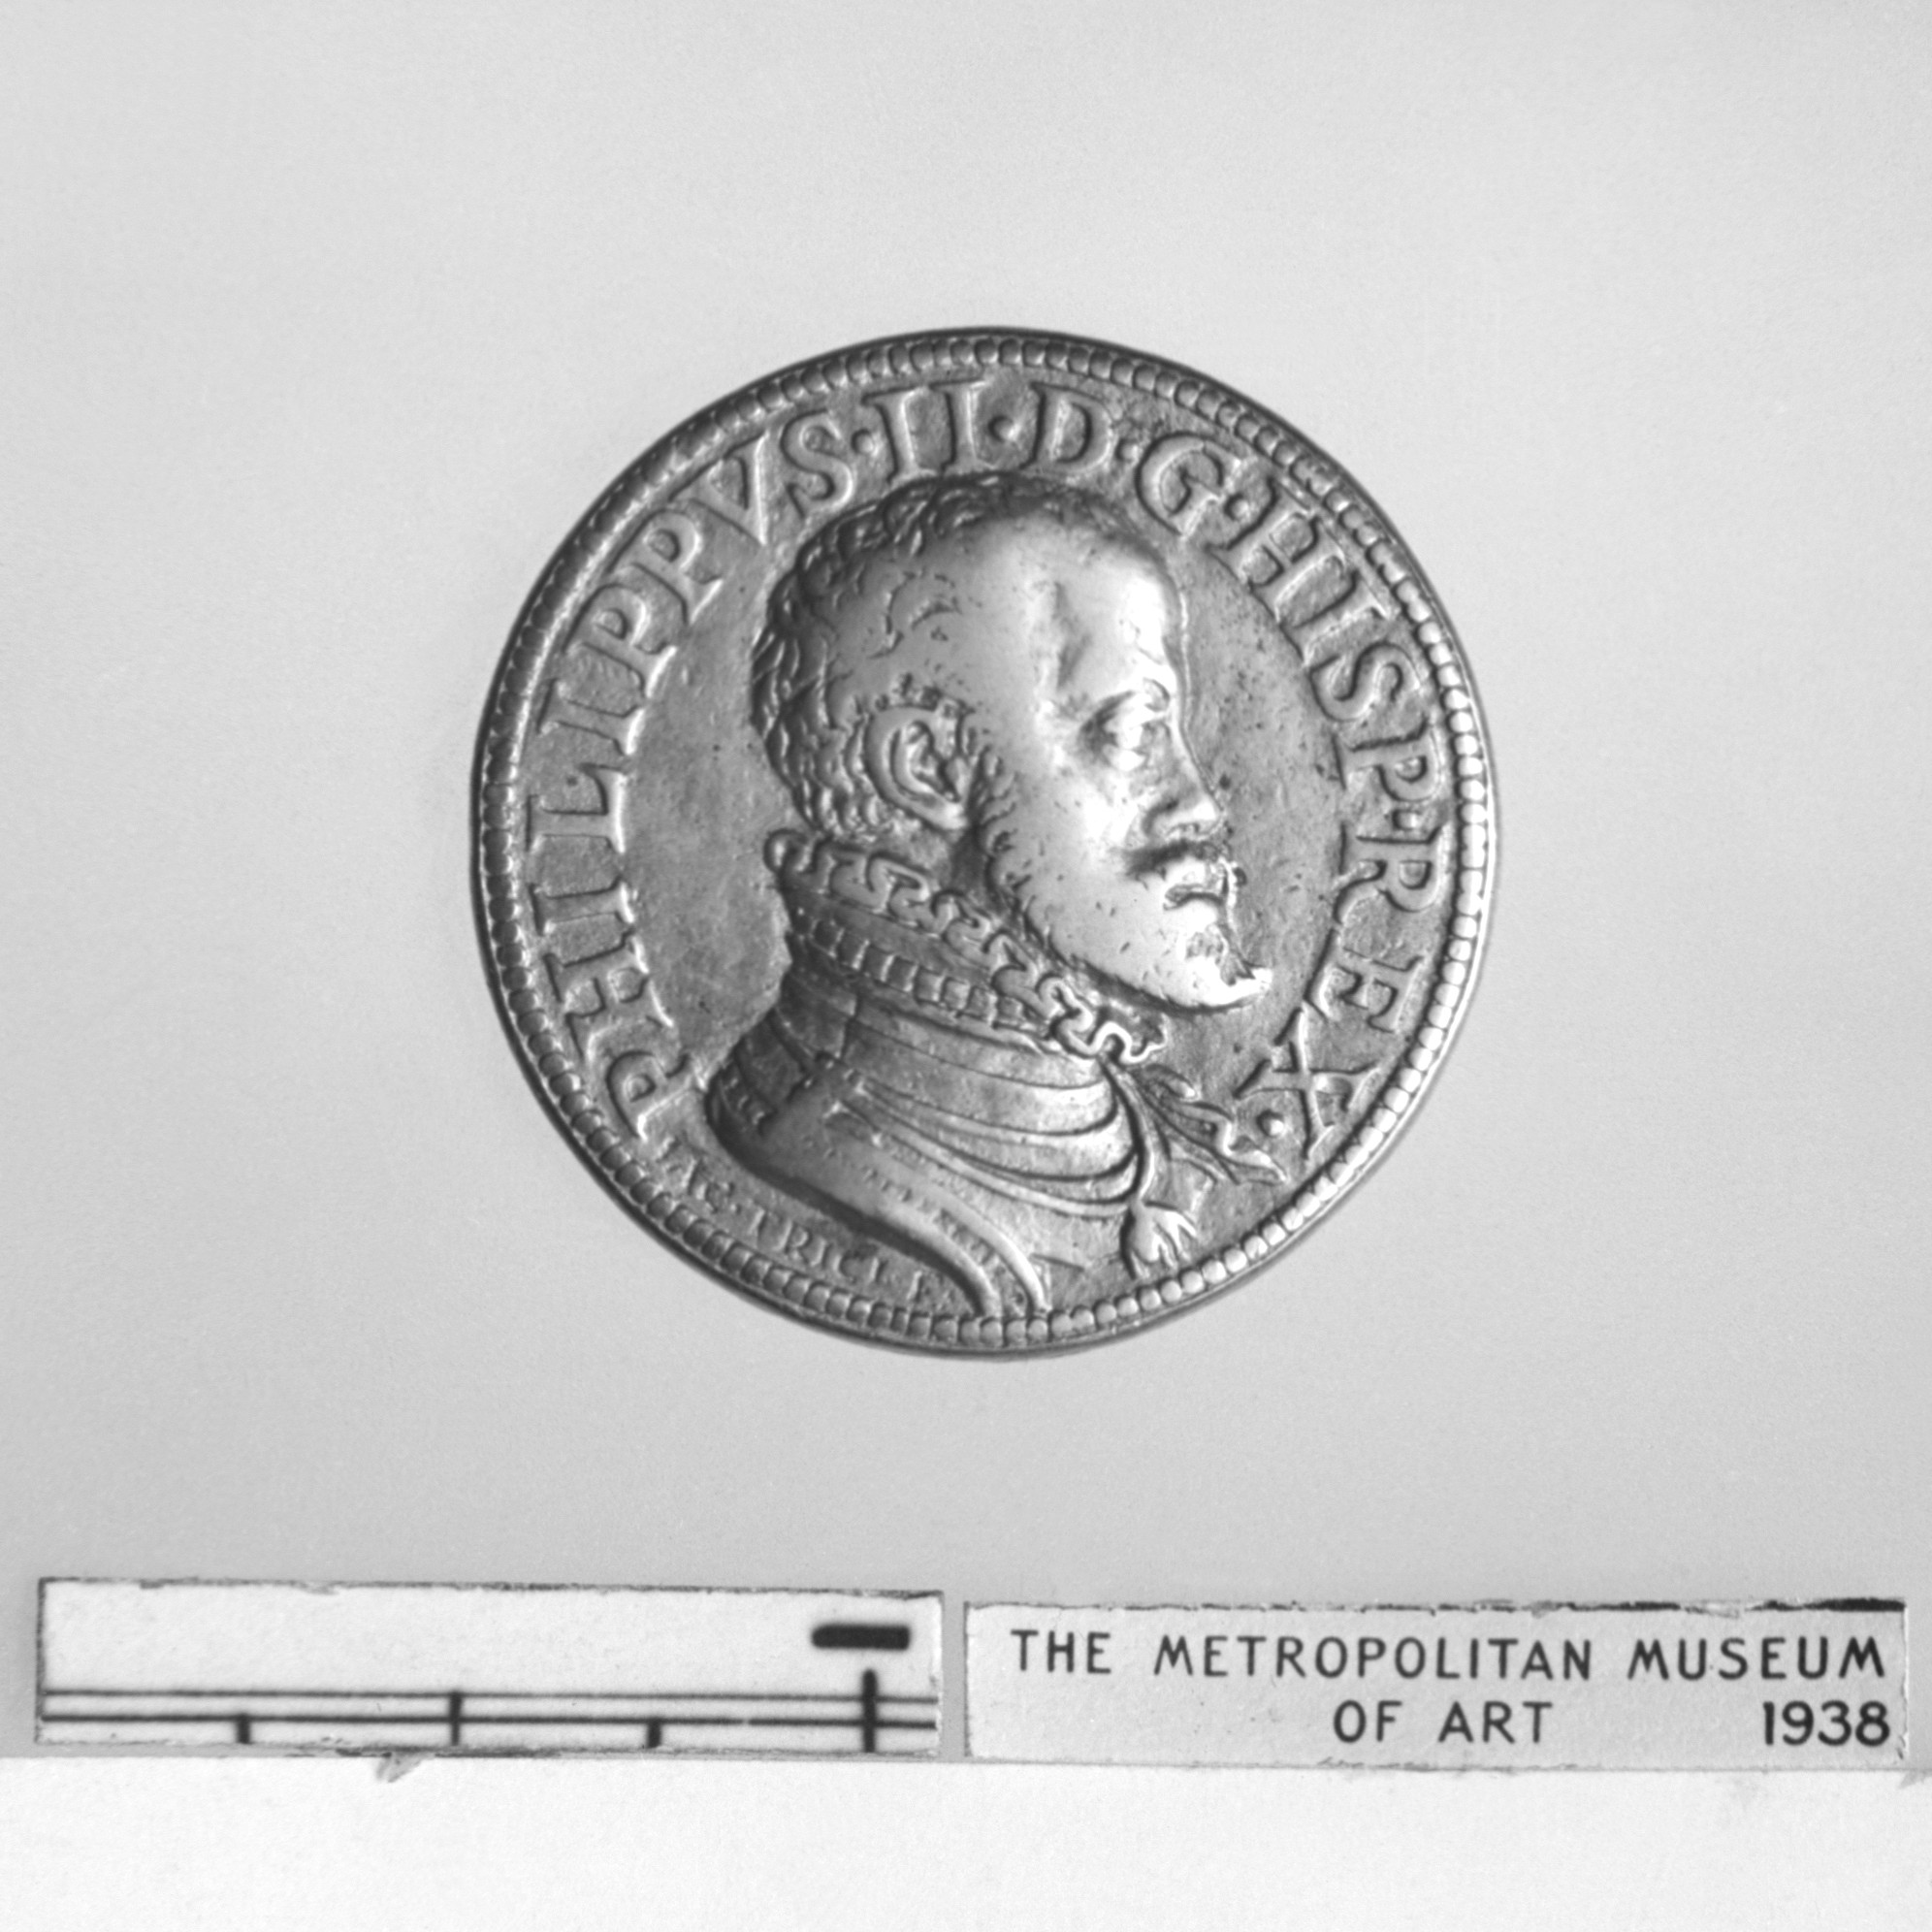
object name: medal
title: Philip II, King of Spain (1527–1598)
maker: jacopo nizolla da trezzo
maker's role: maker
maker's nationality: italian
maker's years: 1515-1589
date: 1551-1575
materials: gold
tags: men,profiles